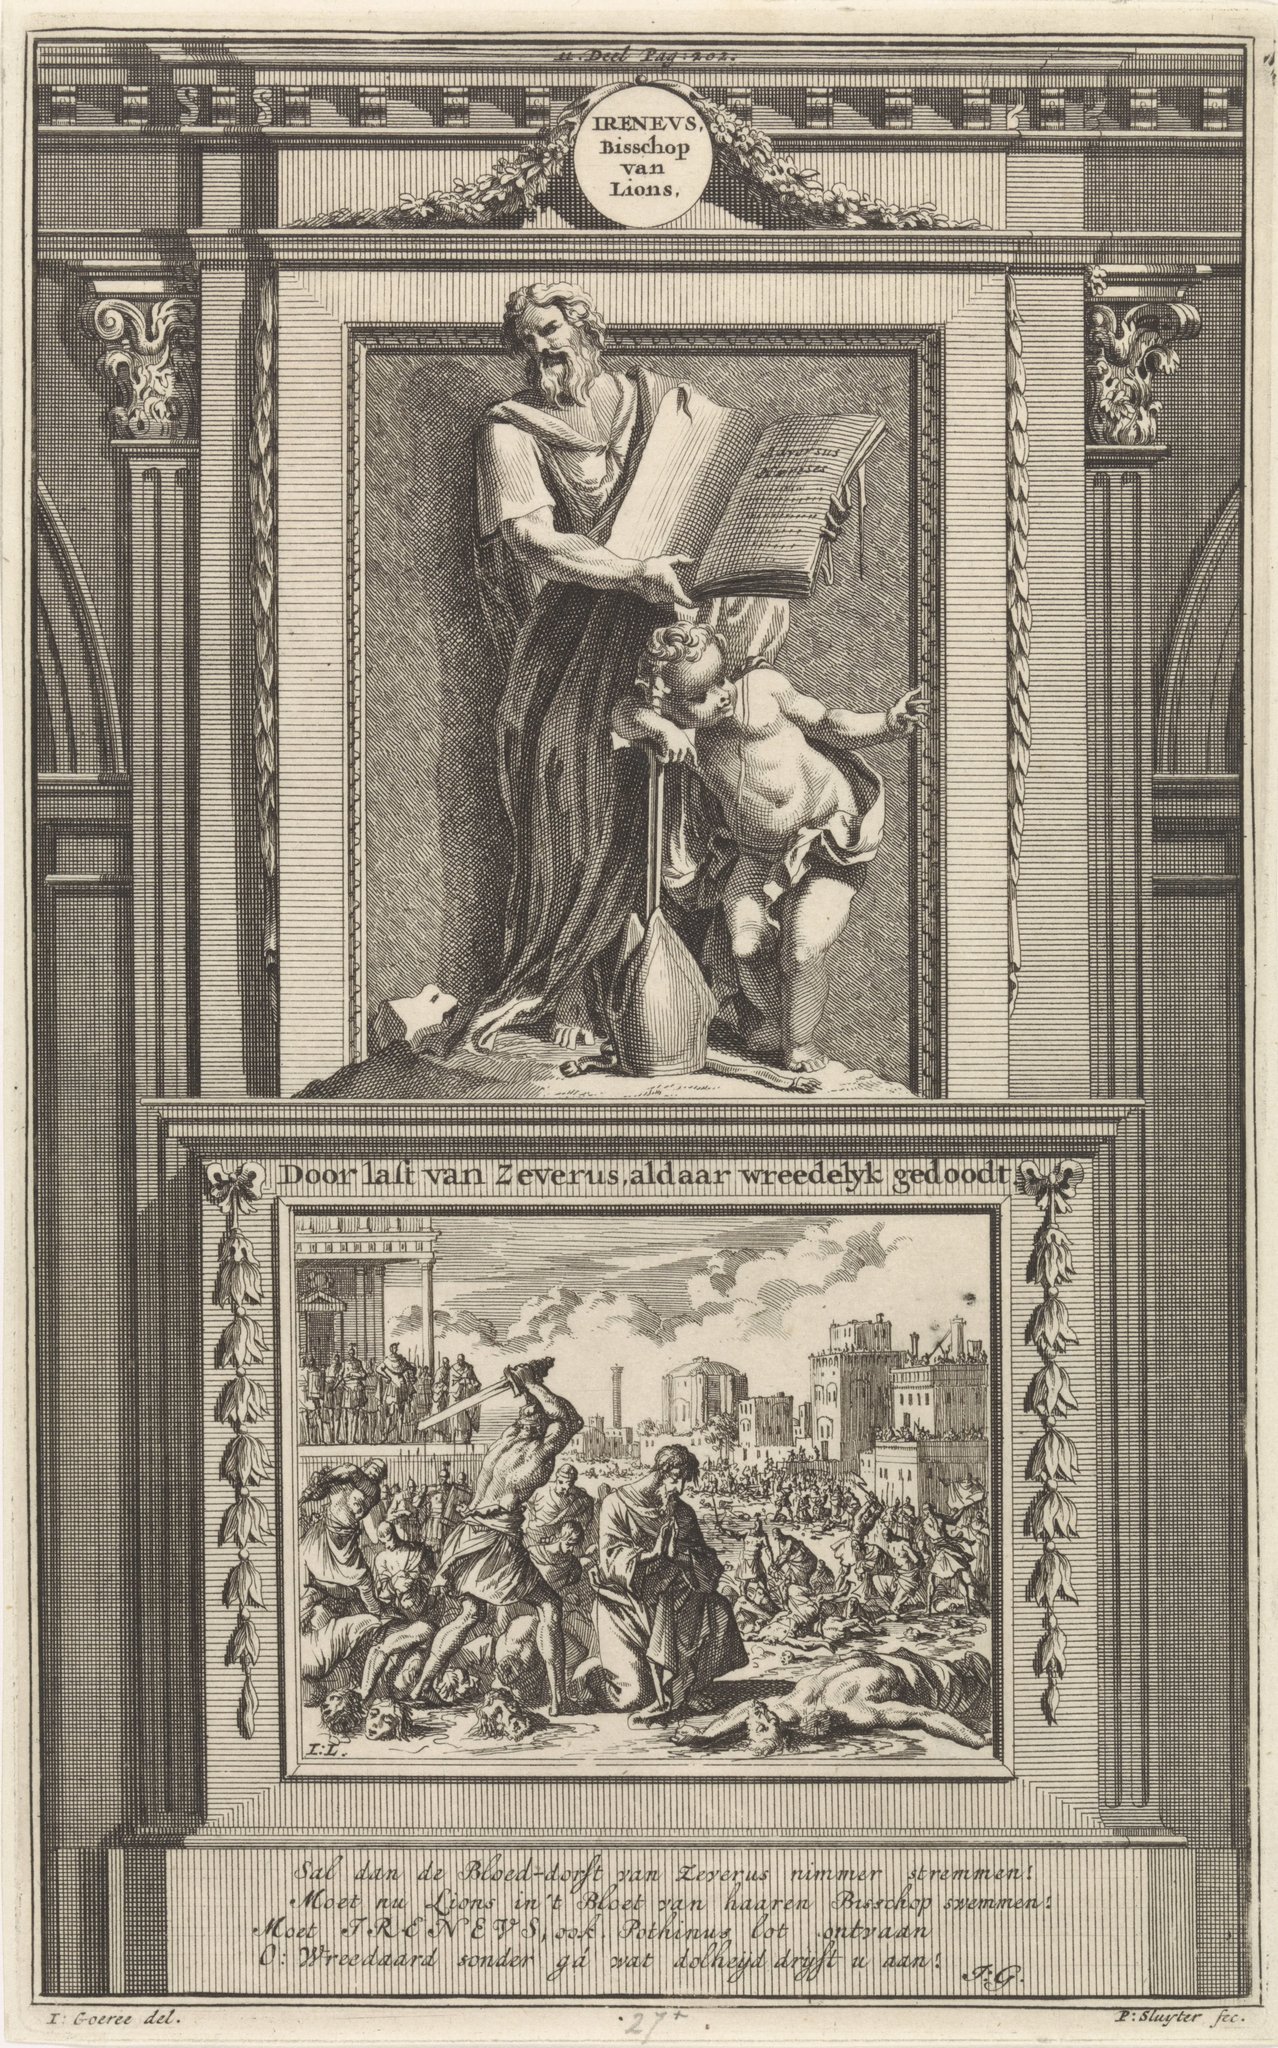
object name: print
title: H. Ireneüs van Lyon, kerkvader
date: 1698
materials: paper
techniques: engraving, etching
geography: amsterdam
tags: male saints (irenaeus of lyon), violent death by beheading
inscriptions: number: ‘27’, collector's mark: Lugt 2228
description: De heilige kerkvader Ireneüs van Lyon staat met een geopend boek in zijn handen. Naast hem steunt een engel op een zwaard dat in een bisschopsmijter is gestoken. Ireneüs staat op een sokkel waar op de voorzijde zijn onthoofding in beeld is gebracht. Prent middenboven gemerkt: II. Deel Pag: 202.